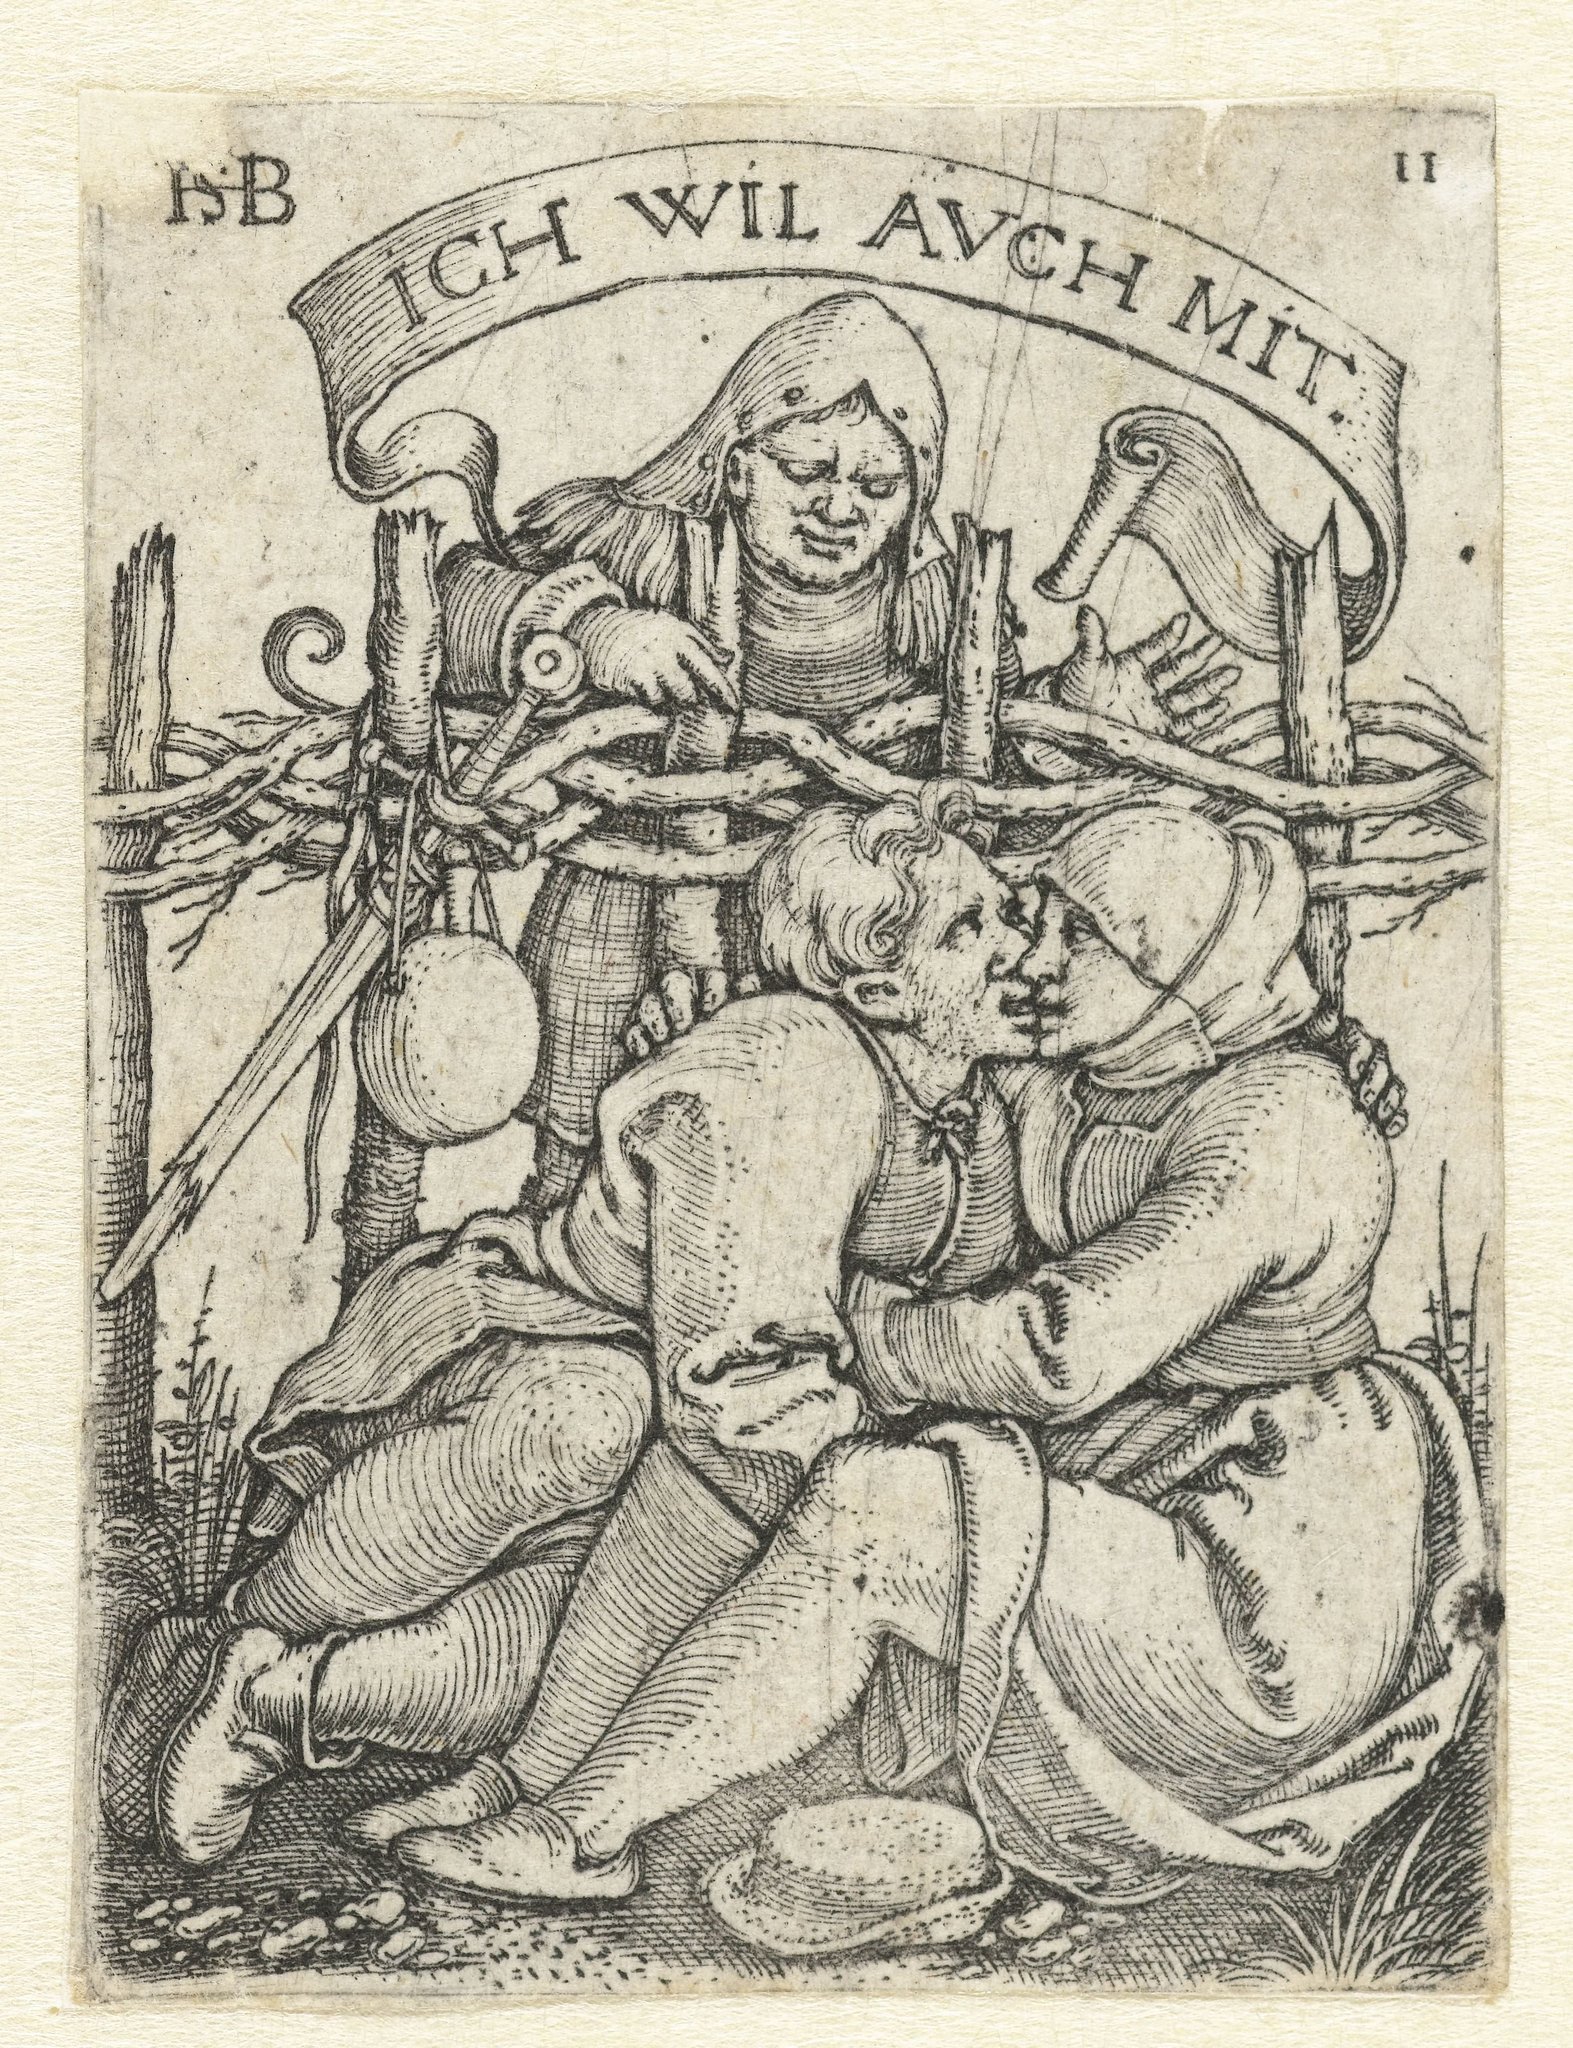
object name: print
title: Boerenfeest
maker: hans sebald beham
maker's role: designer, draughtsman, print maker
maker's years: 1500-1550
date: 1537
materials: paper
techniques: engraving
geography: frankfurt am main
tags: peeping, voyeur, lovers; courting, flirting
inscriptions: collector's mark: Lugt 2228a